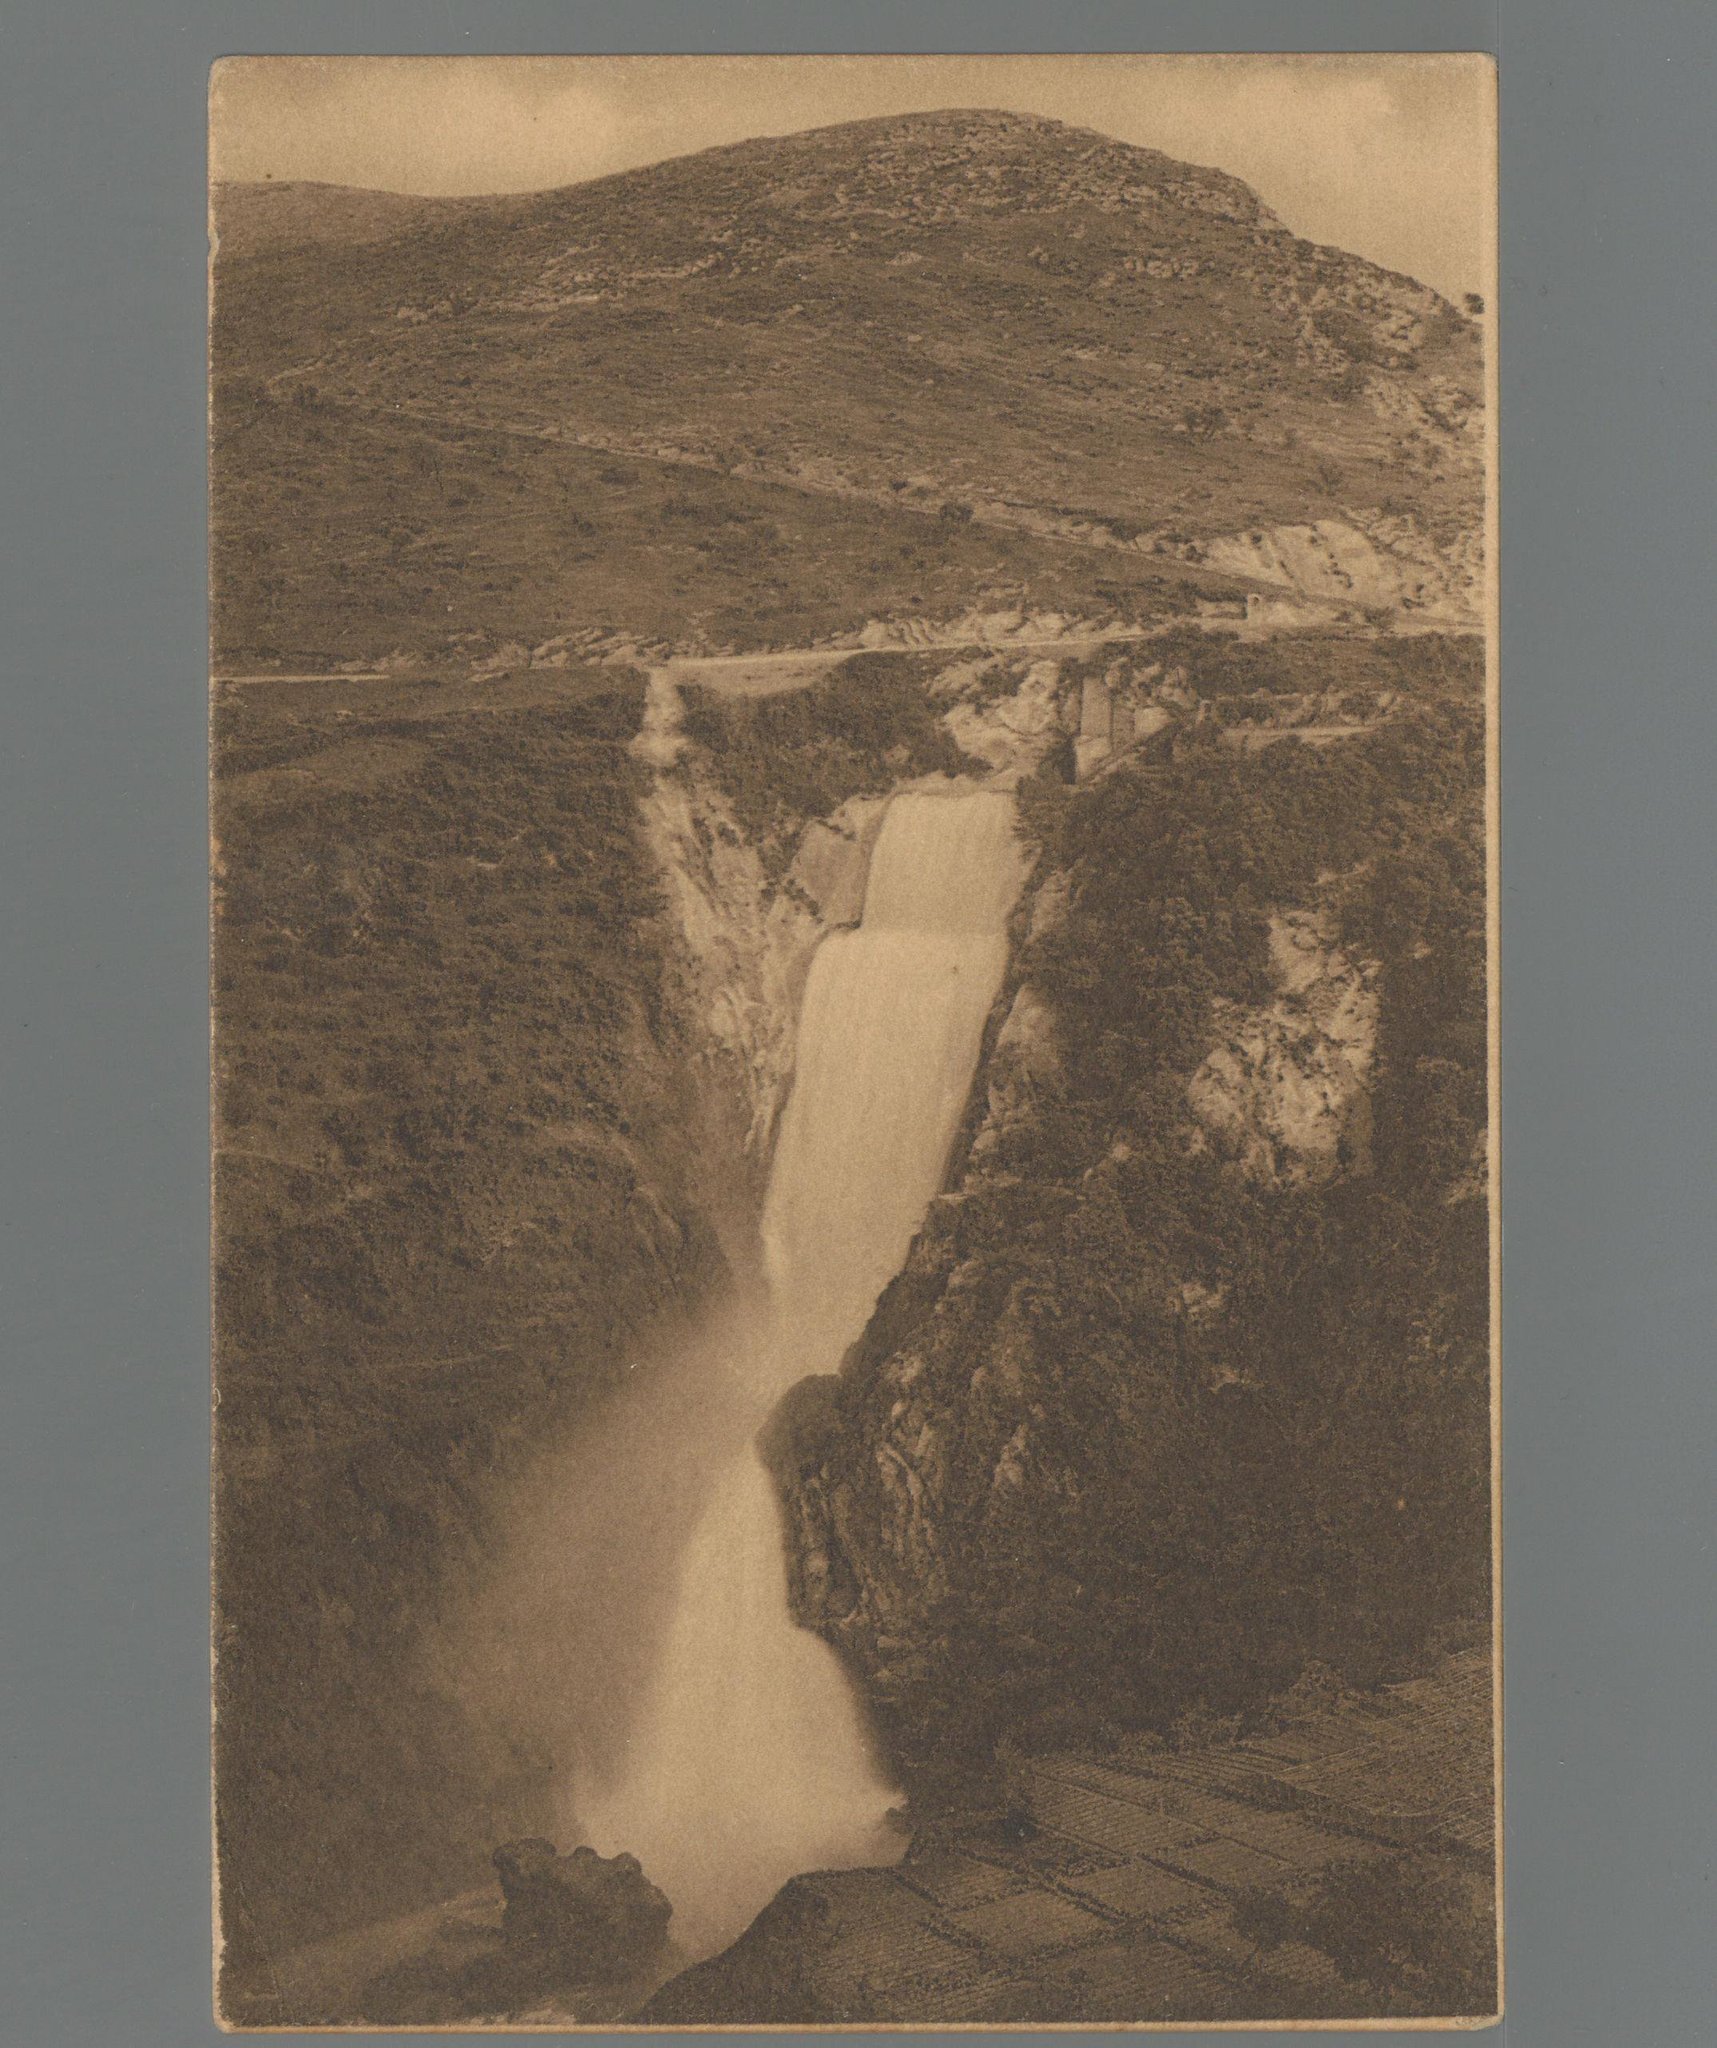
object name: ansichtkaart, prentbriefkaart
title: Tivoli (dintorni di Roma). Grande Cascata dell'Aniene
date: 1906-1920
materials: cardboard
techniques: photograph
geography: italy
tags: waterfall, mountains, tivoli